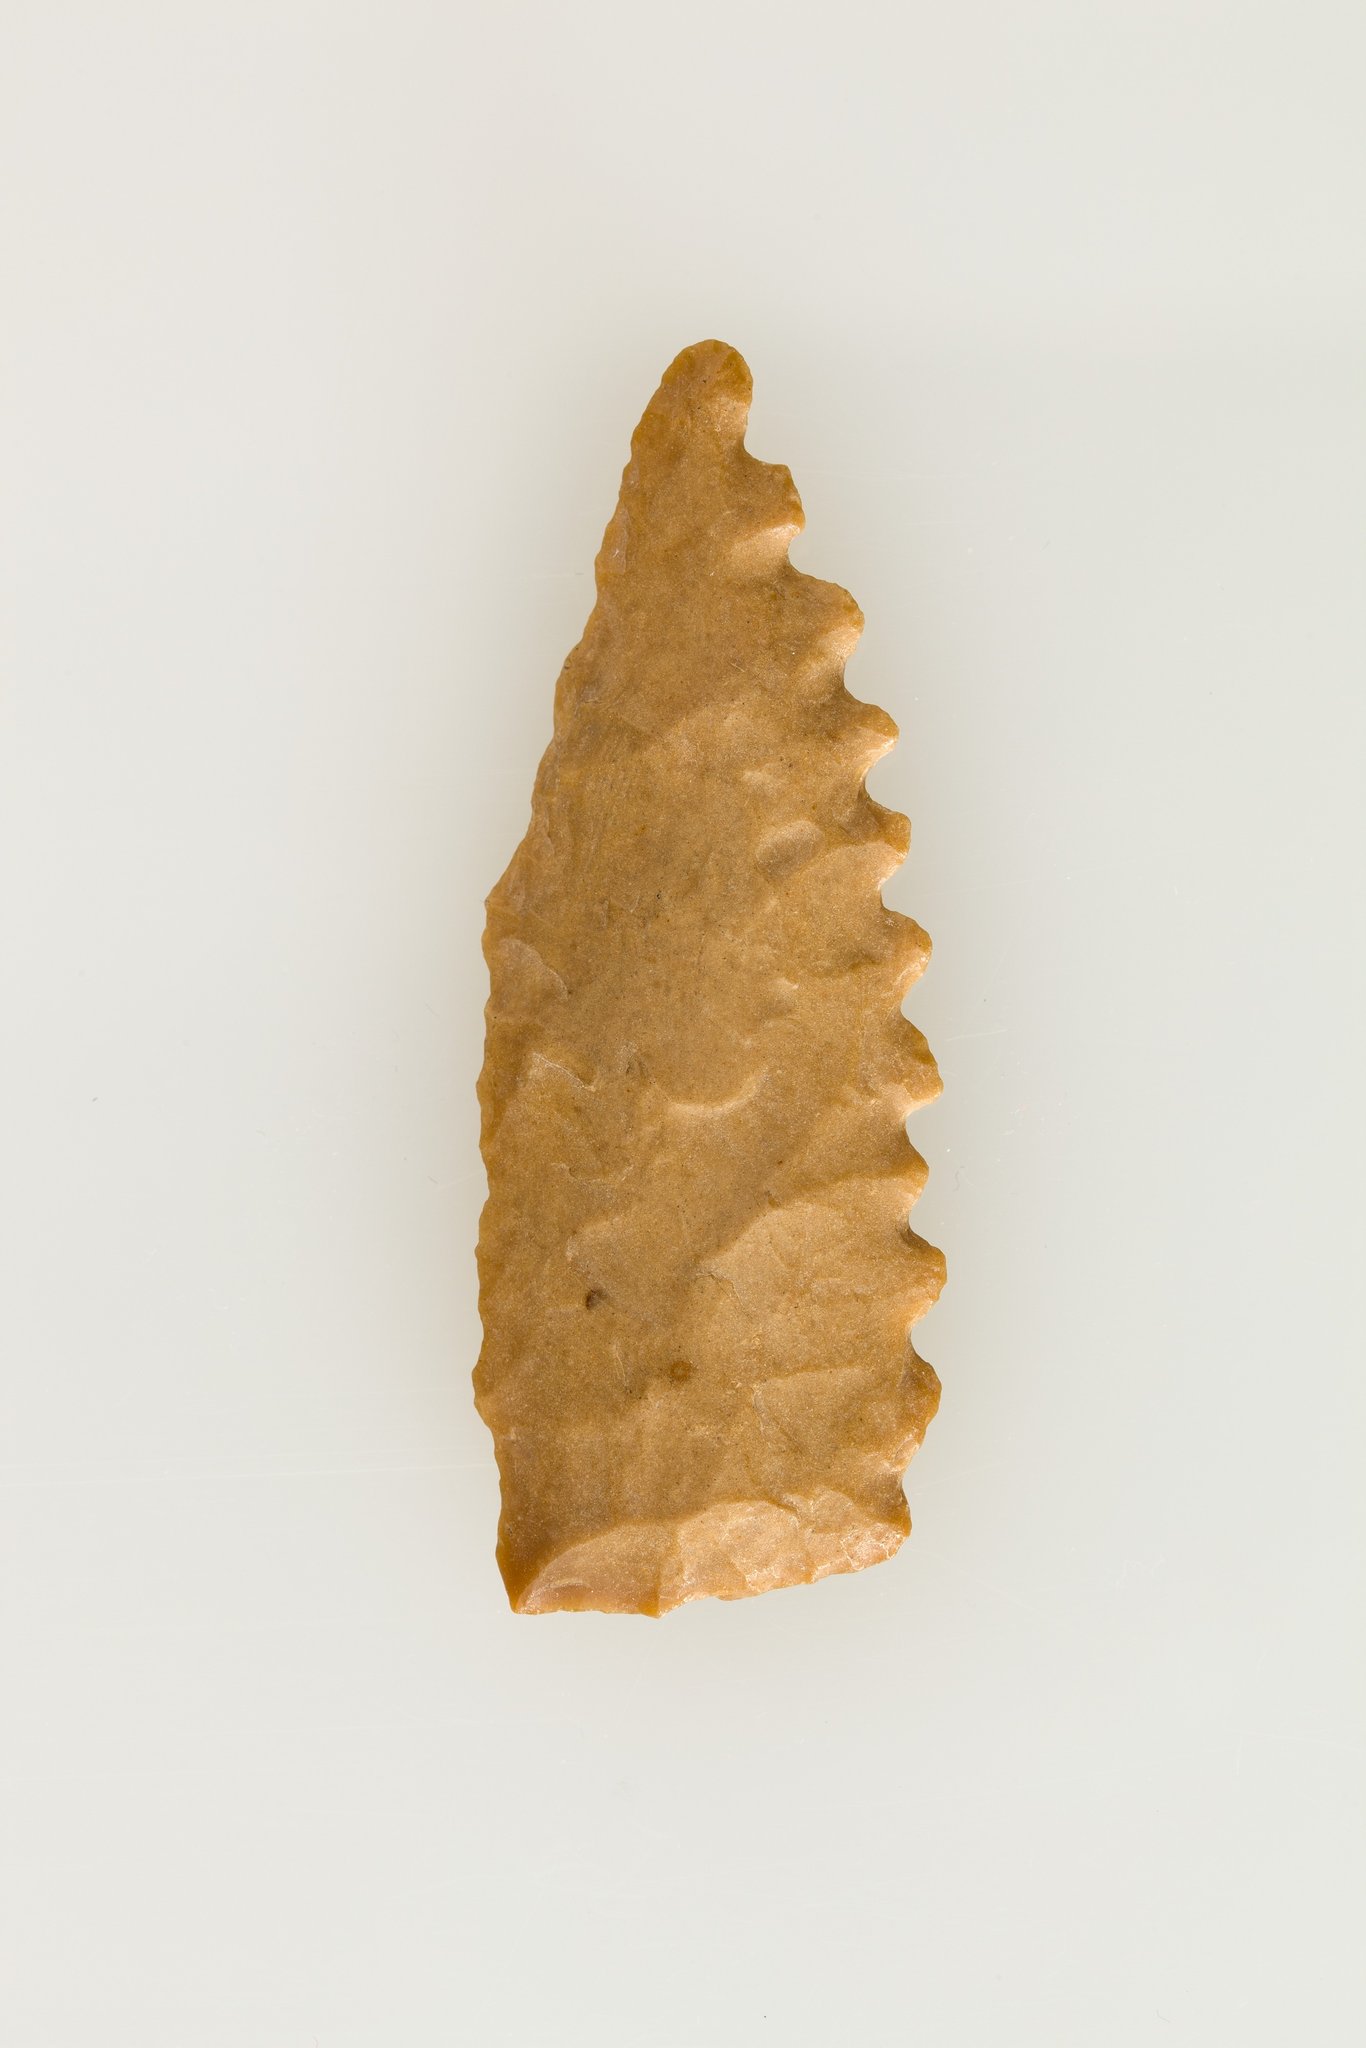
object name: sickle, insert, denticulate, bifacial, tool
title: Bifacial Sickle Insert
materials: stone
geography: egypt